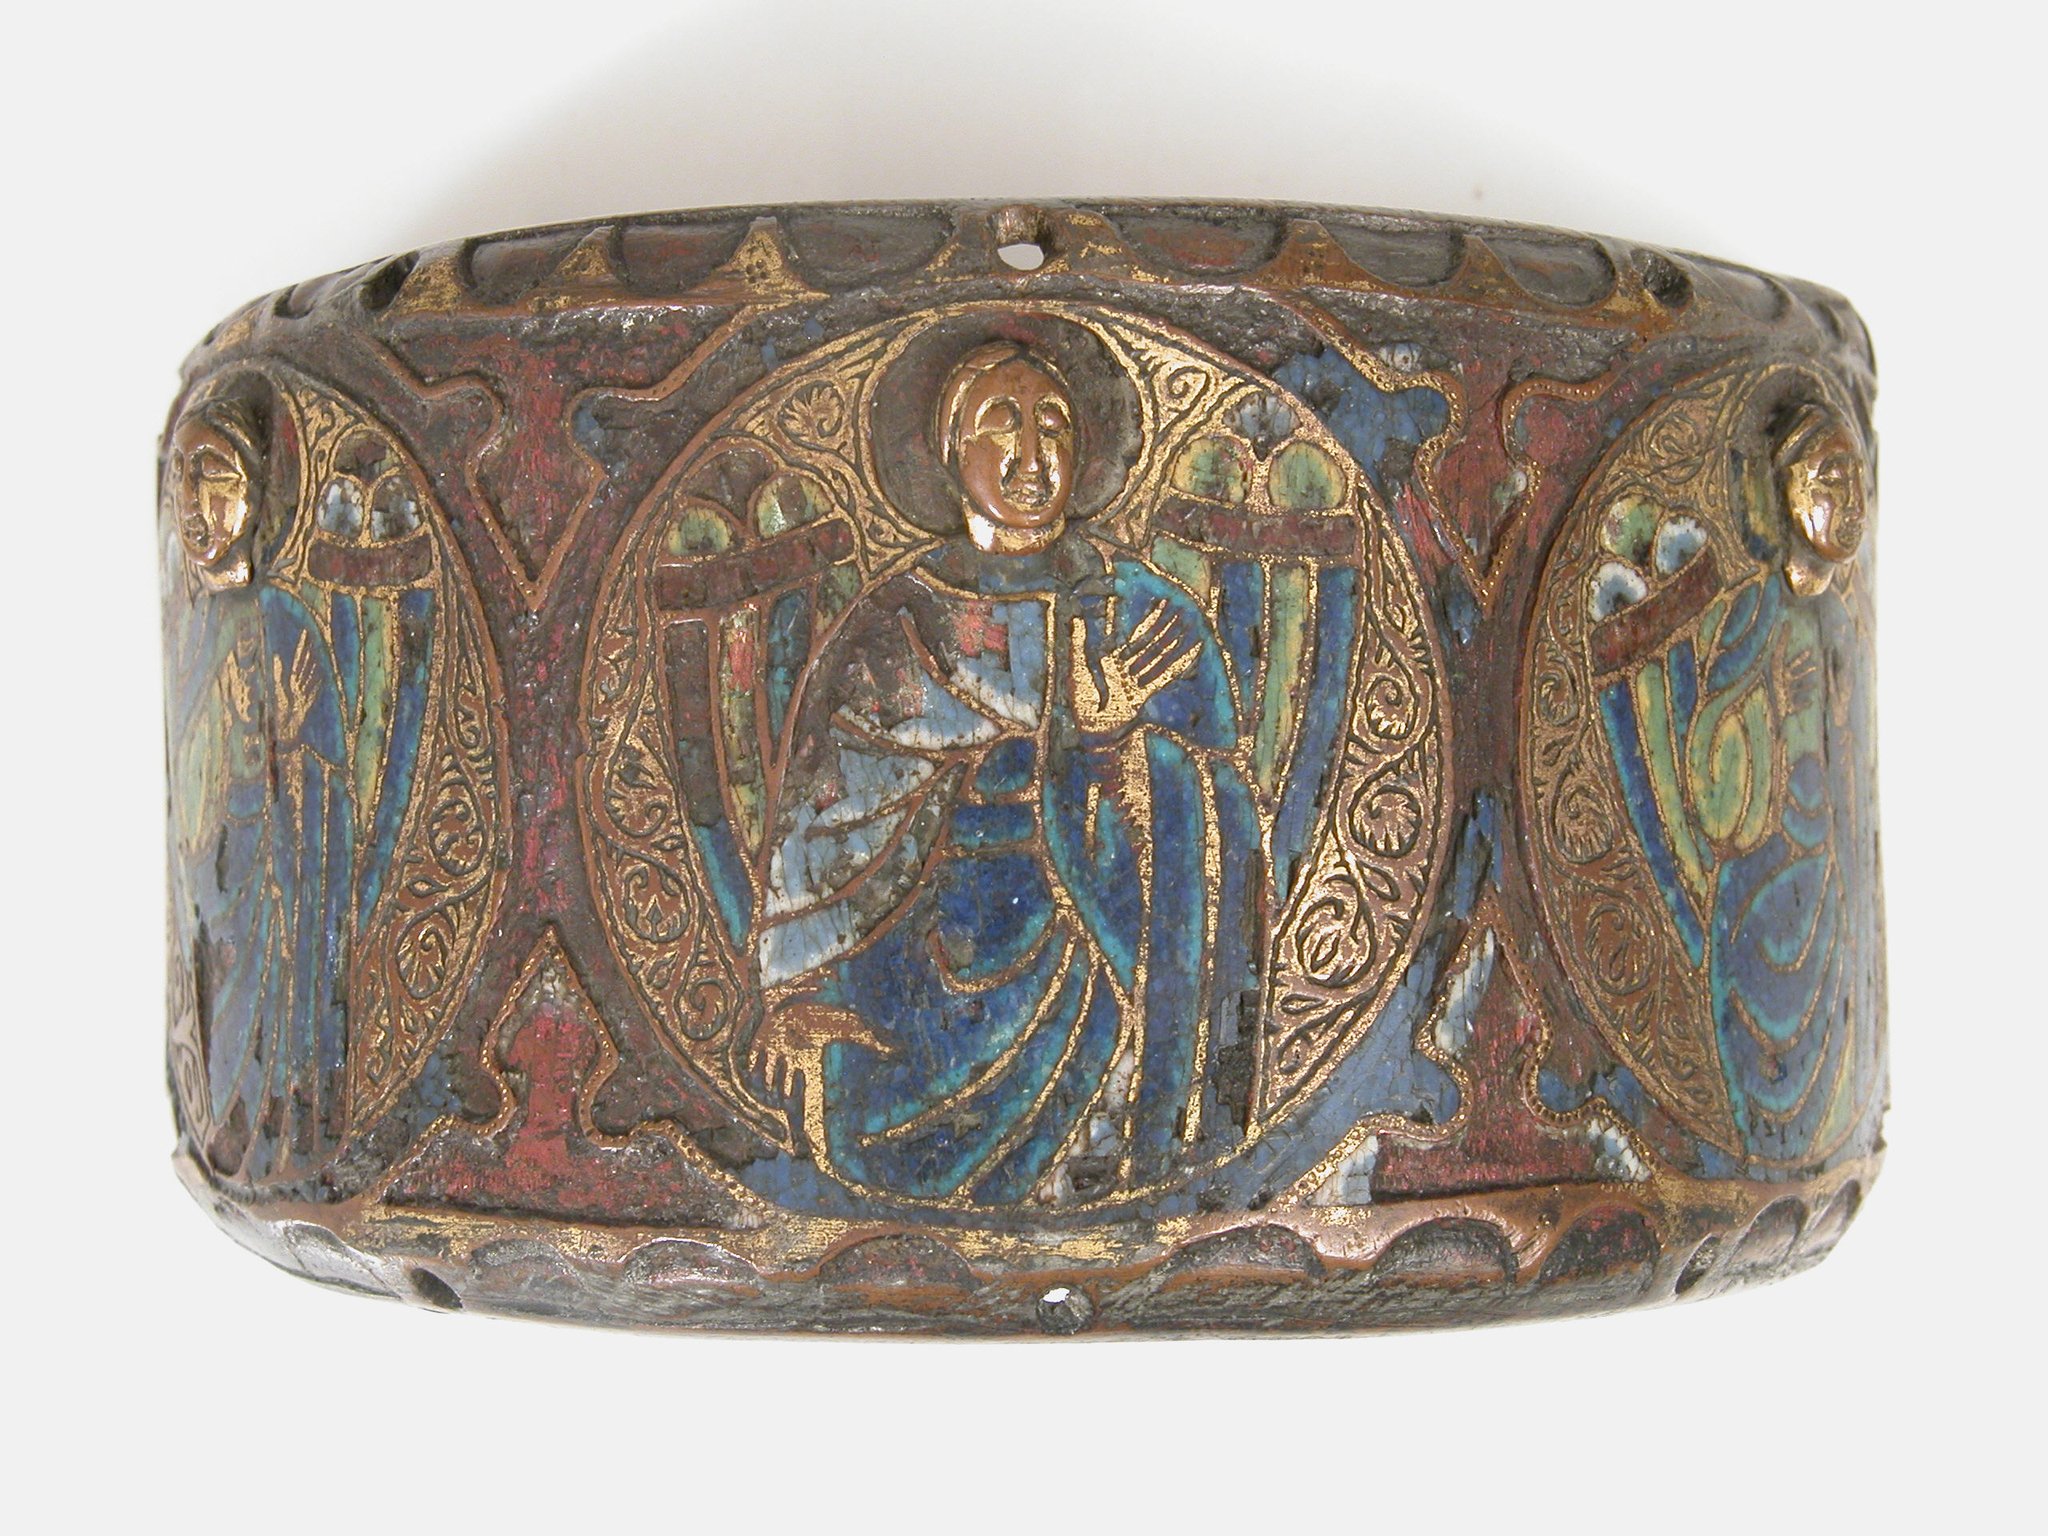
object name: band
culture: french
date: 1201-1233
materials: gilt copper, enamel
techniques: enamel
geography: france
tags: men,women